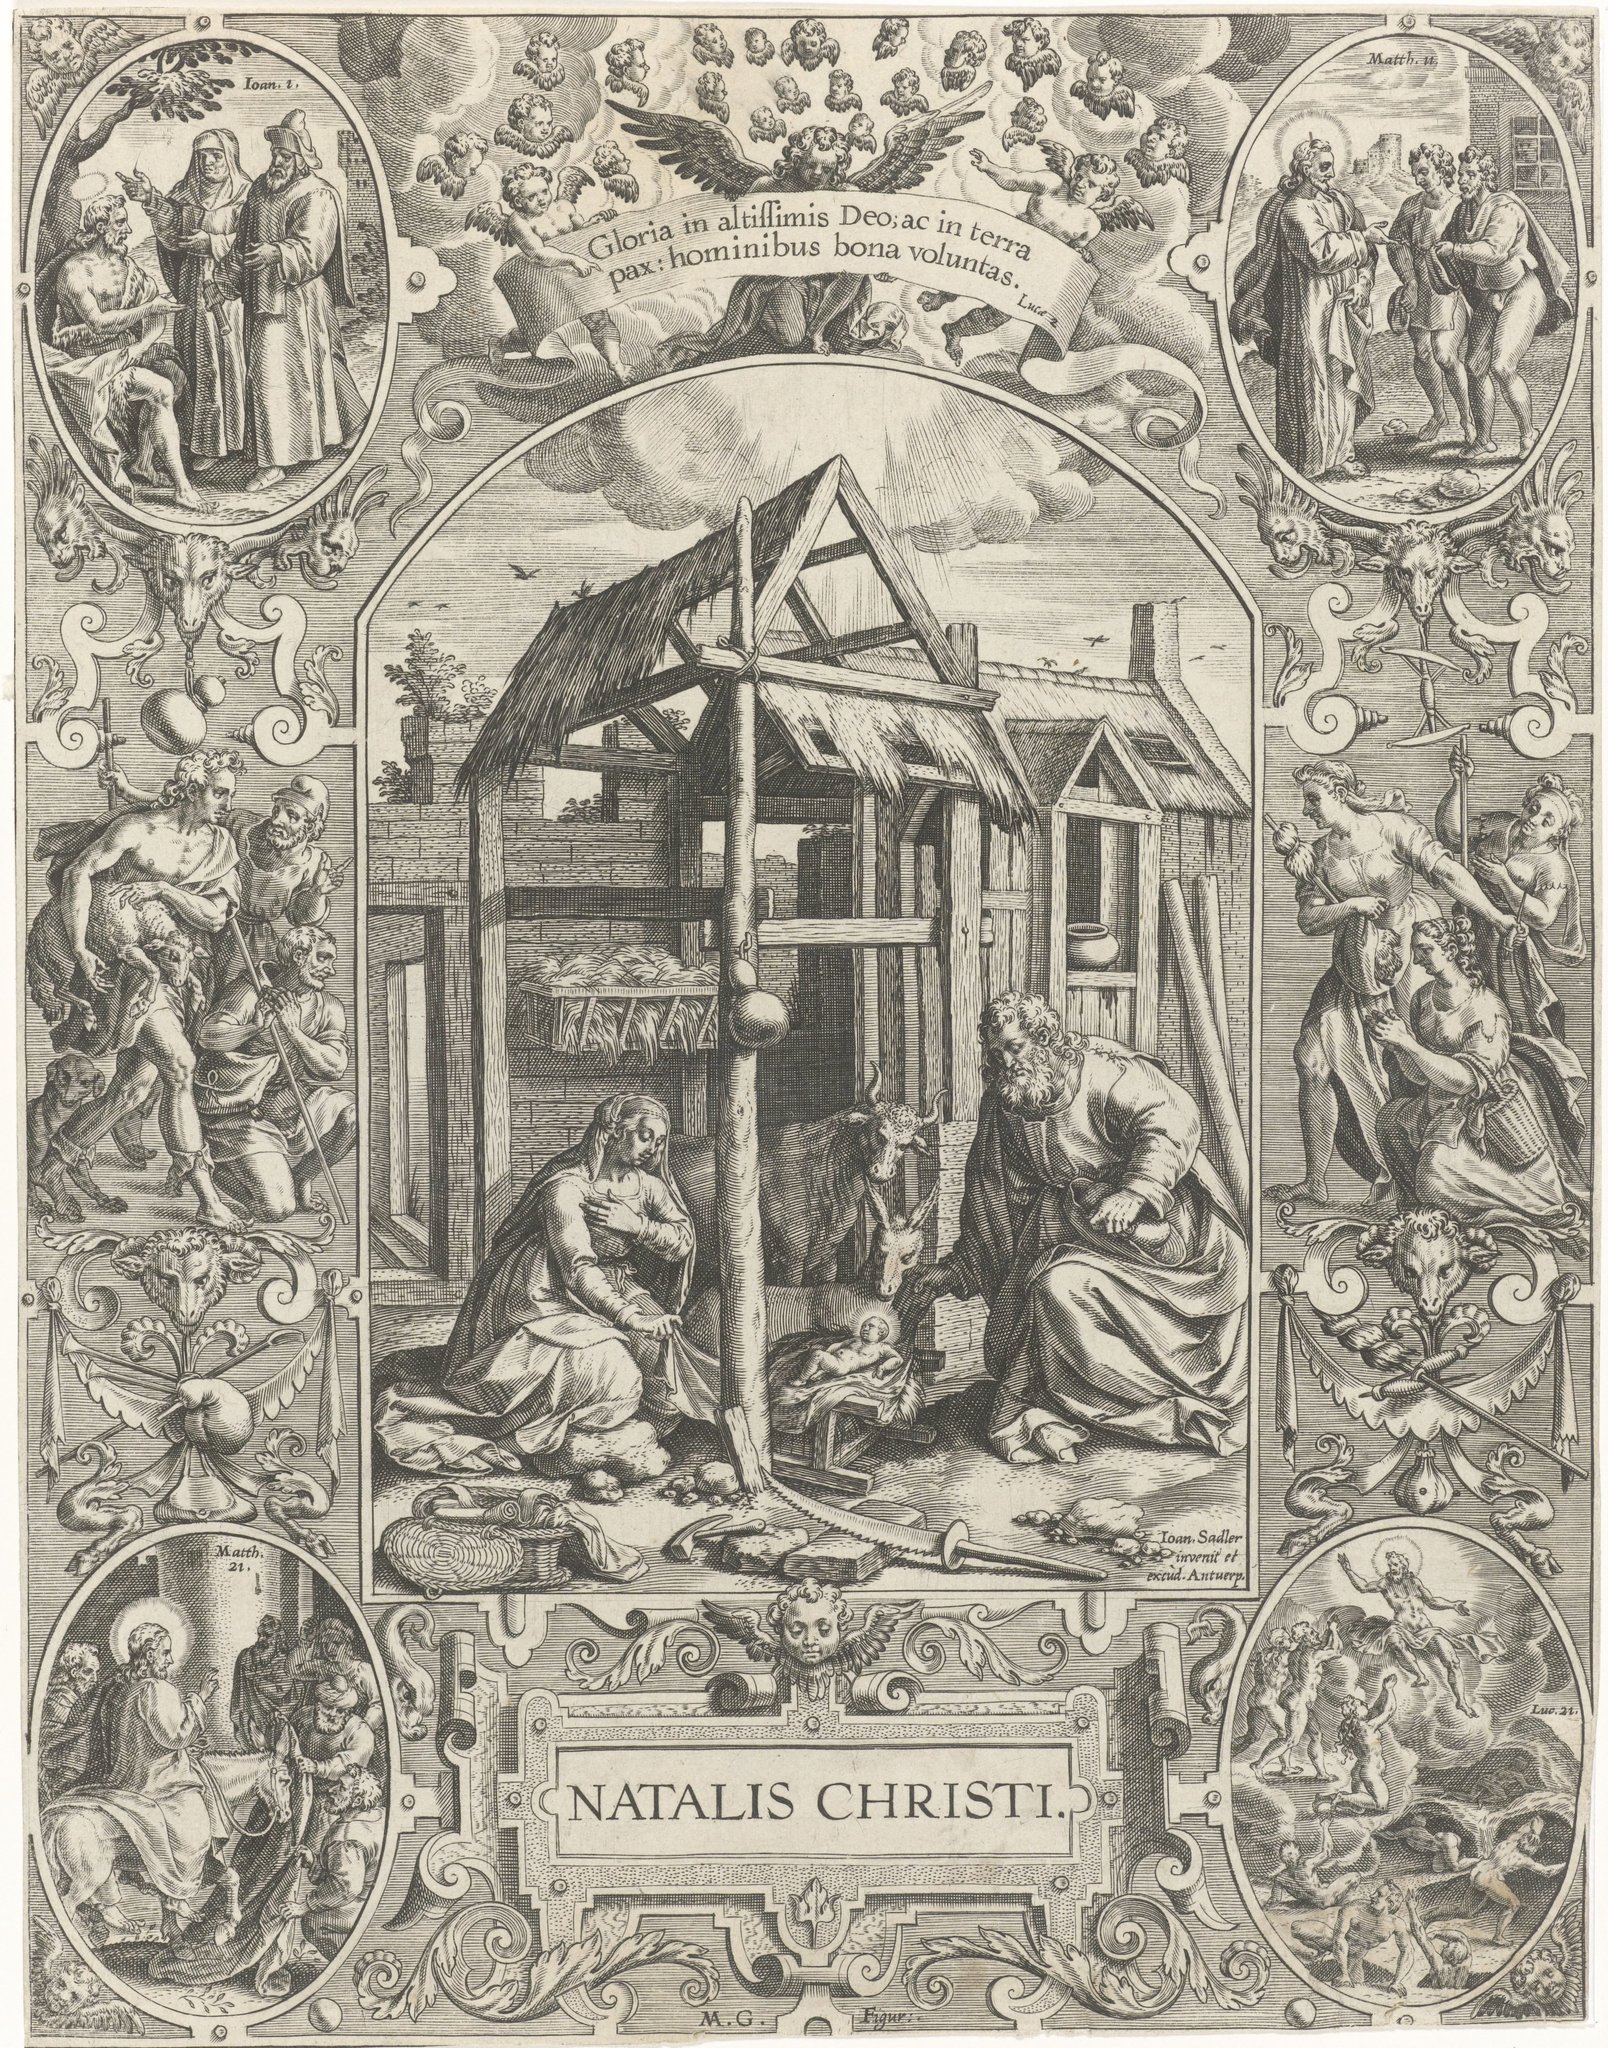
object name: print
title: De vier belangrijkste Christelijke feestdagen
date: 1560-1600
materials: paper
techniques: engraving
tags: christmas (ecclesiastical feast), comprehensive representation of last judgement: christ (with sword and lily), often surrounded by elders and sometimes accompanied by mary and john the baptist, appears in the sky with trumpeting angels (and sometimes angels holding the instruments of the passion); after the resurrection of the dead the blessed are led to heaven by angels, and the damned are dragged into hell by devils, john the baptist in prison, john the baptist disputing, tools, aids, implements ~ crafts and industries: saw, entry into jerusalem: people spreading their clothes before christ on the ass, and waving palm branches (matthew 21:1-11, 21:14-16; mark 11:1-11; luke 19:28-40; john 12:12-19), mary, joseph and the new-born christ (nativity)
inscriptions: collector's mark: Lugt 2228, collector's mark: Lugt 698, collector's mark: Lugt 2233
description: Maria en Jozef geknield bij Christus in de kribbe; achter hen de os en de ezel, in een stal met gehavend dak. In ornamentlijst met links de herders, rechts de vrouwen die het kind komen aanbidden. In de vier hoeken scènes uit het Nieuwe Testament in ovalen. Middenboven engelenkoren bij een wimpel waarop de Latijnse tekst: Vera...canunt.